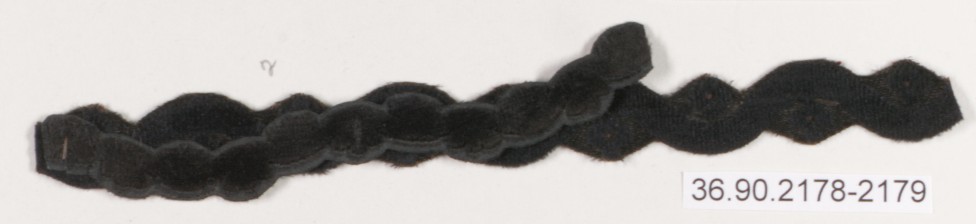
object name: piece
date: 1801-1900